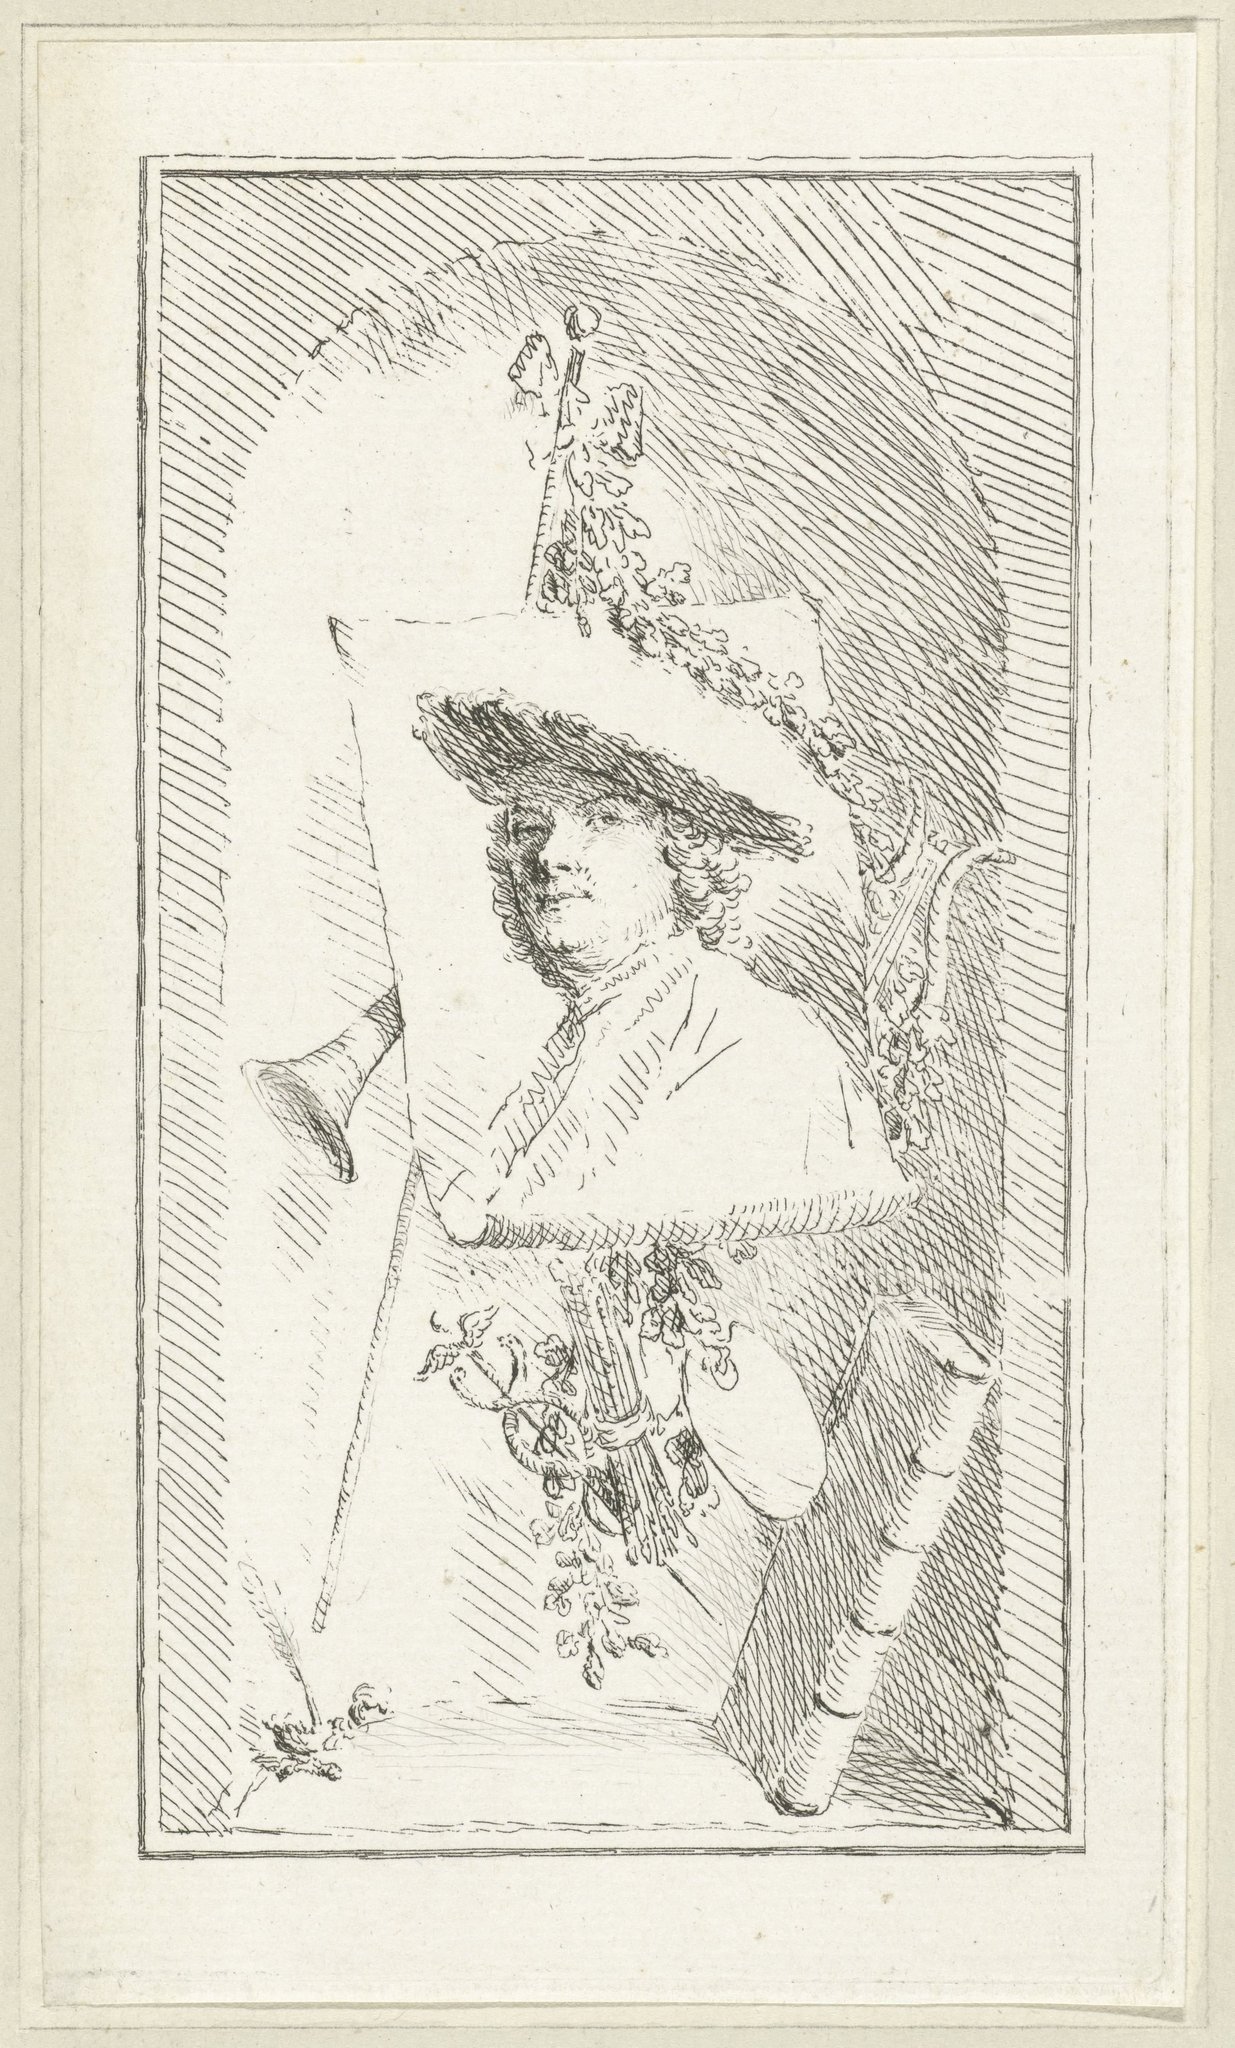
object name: print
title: Zelfportret van Cornelis Ploos van Amstel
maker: cornelis ploos van amstel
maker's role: draughtsman, print maker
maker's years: 1726-1798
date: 1748-1798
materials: paper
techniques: etching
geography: amsterdam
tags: amsterdam, print maker, draughtsman, cornelis ploos van amstel, palette, brushes ~ implements of painter, caduceus (staff with two snakes, attribute of mercury)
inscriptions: collector's mark: Lugt 2760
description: Zelfportret van kunstenaar en prentmaker Cornelis Ploos van Amstel. Het portret wordt omgeven door een schilderstok, lier, palet, penselenbundel, caduceus, boek en schrijfveer.